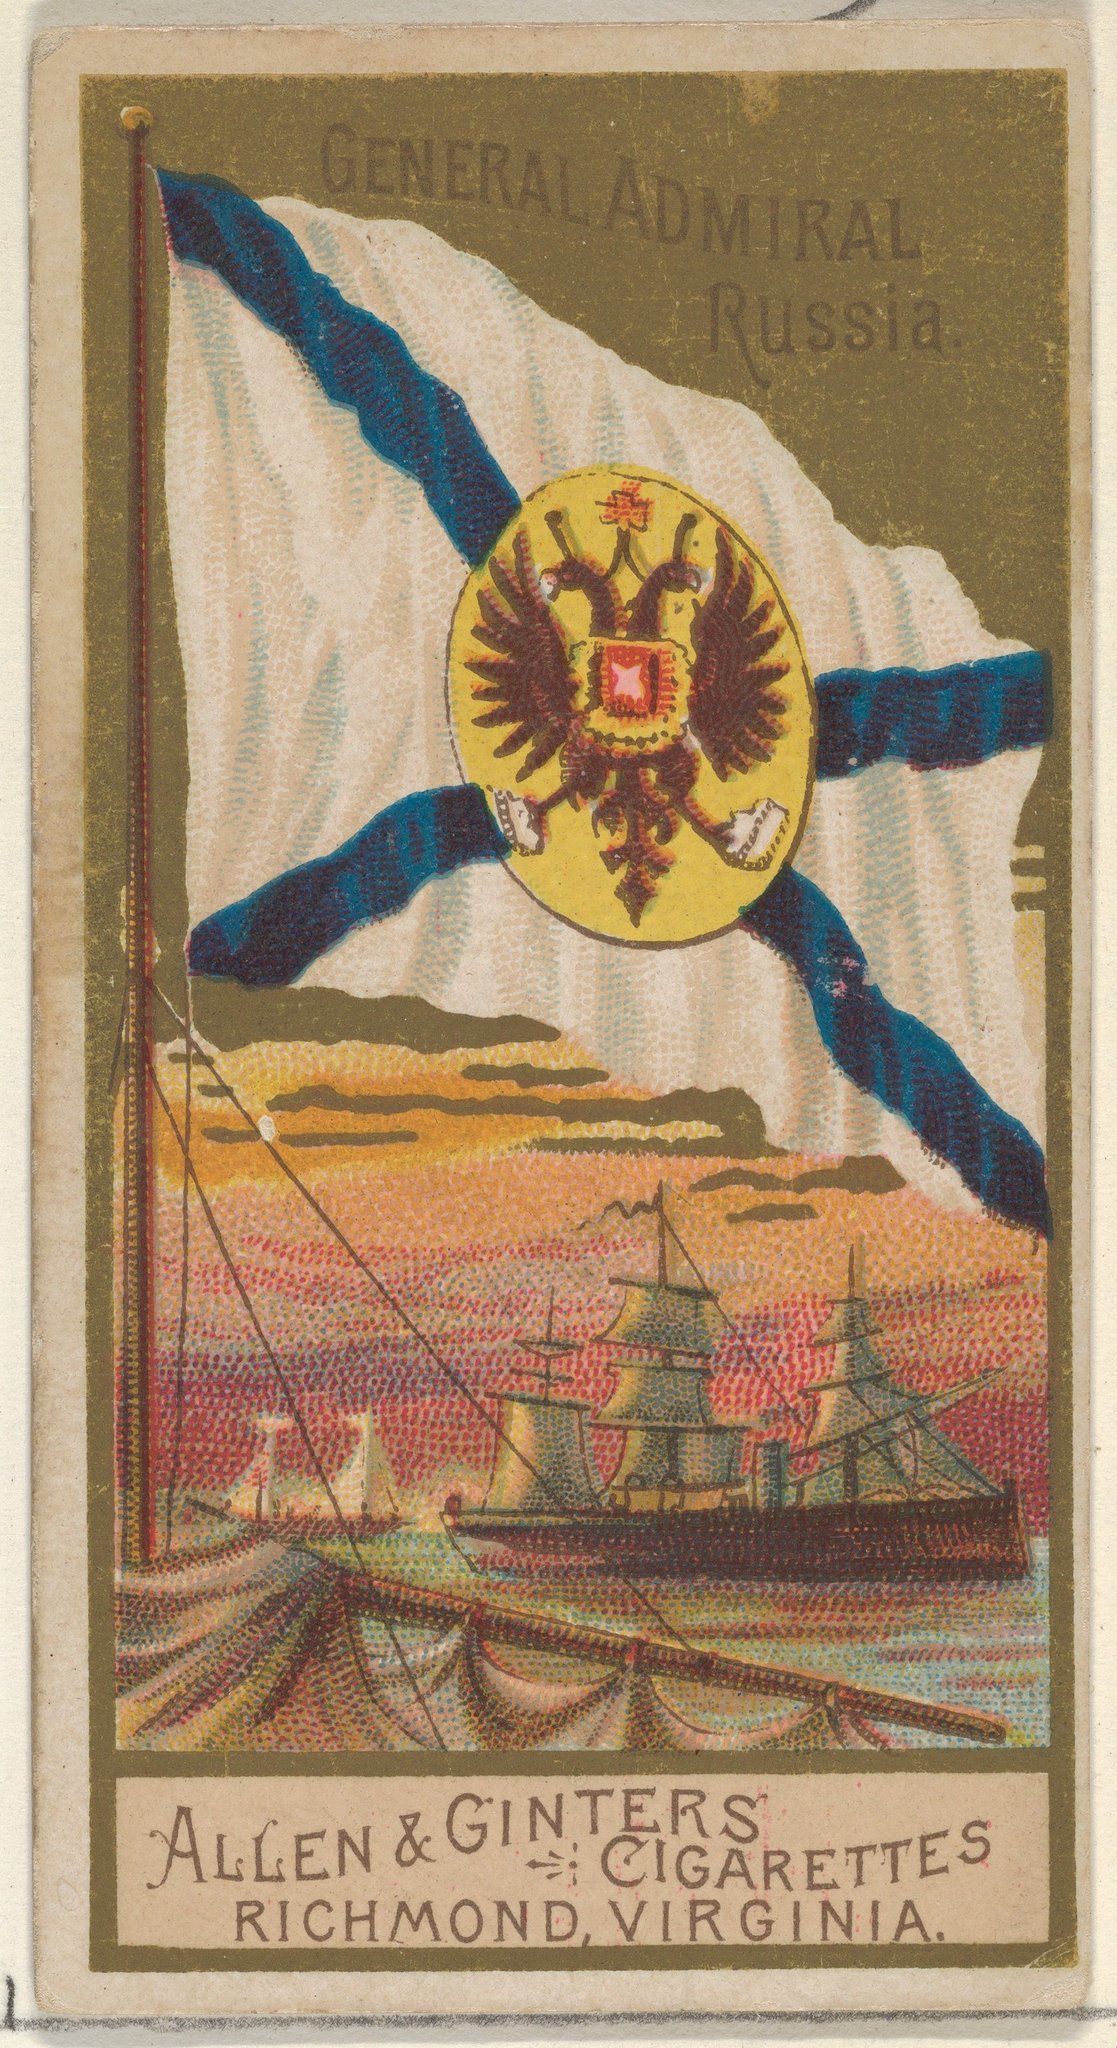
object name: print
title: General Admiral, Russia, from the Naval Flags series (N17) for Allen & Ginter Cigarettes Brands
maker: allen & ginter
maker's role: publisher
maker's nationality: american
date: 1888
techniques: color lithograph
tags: coat of arms,flags